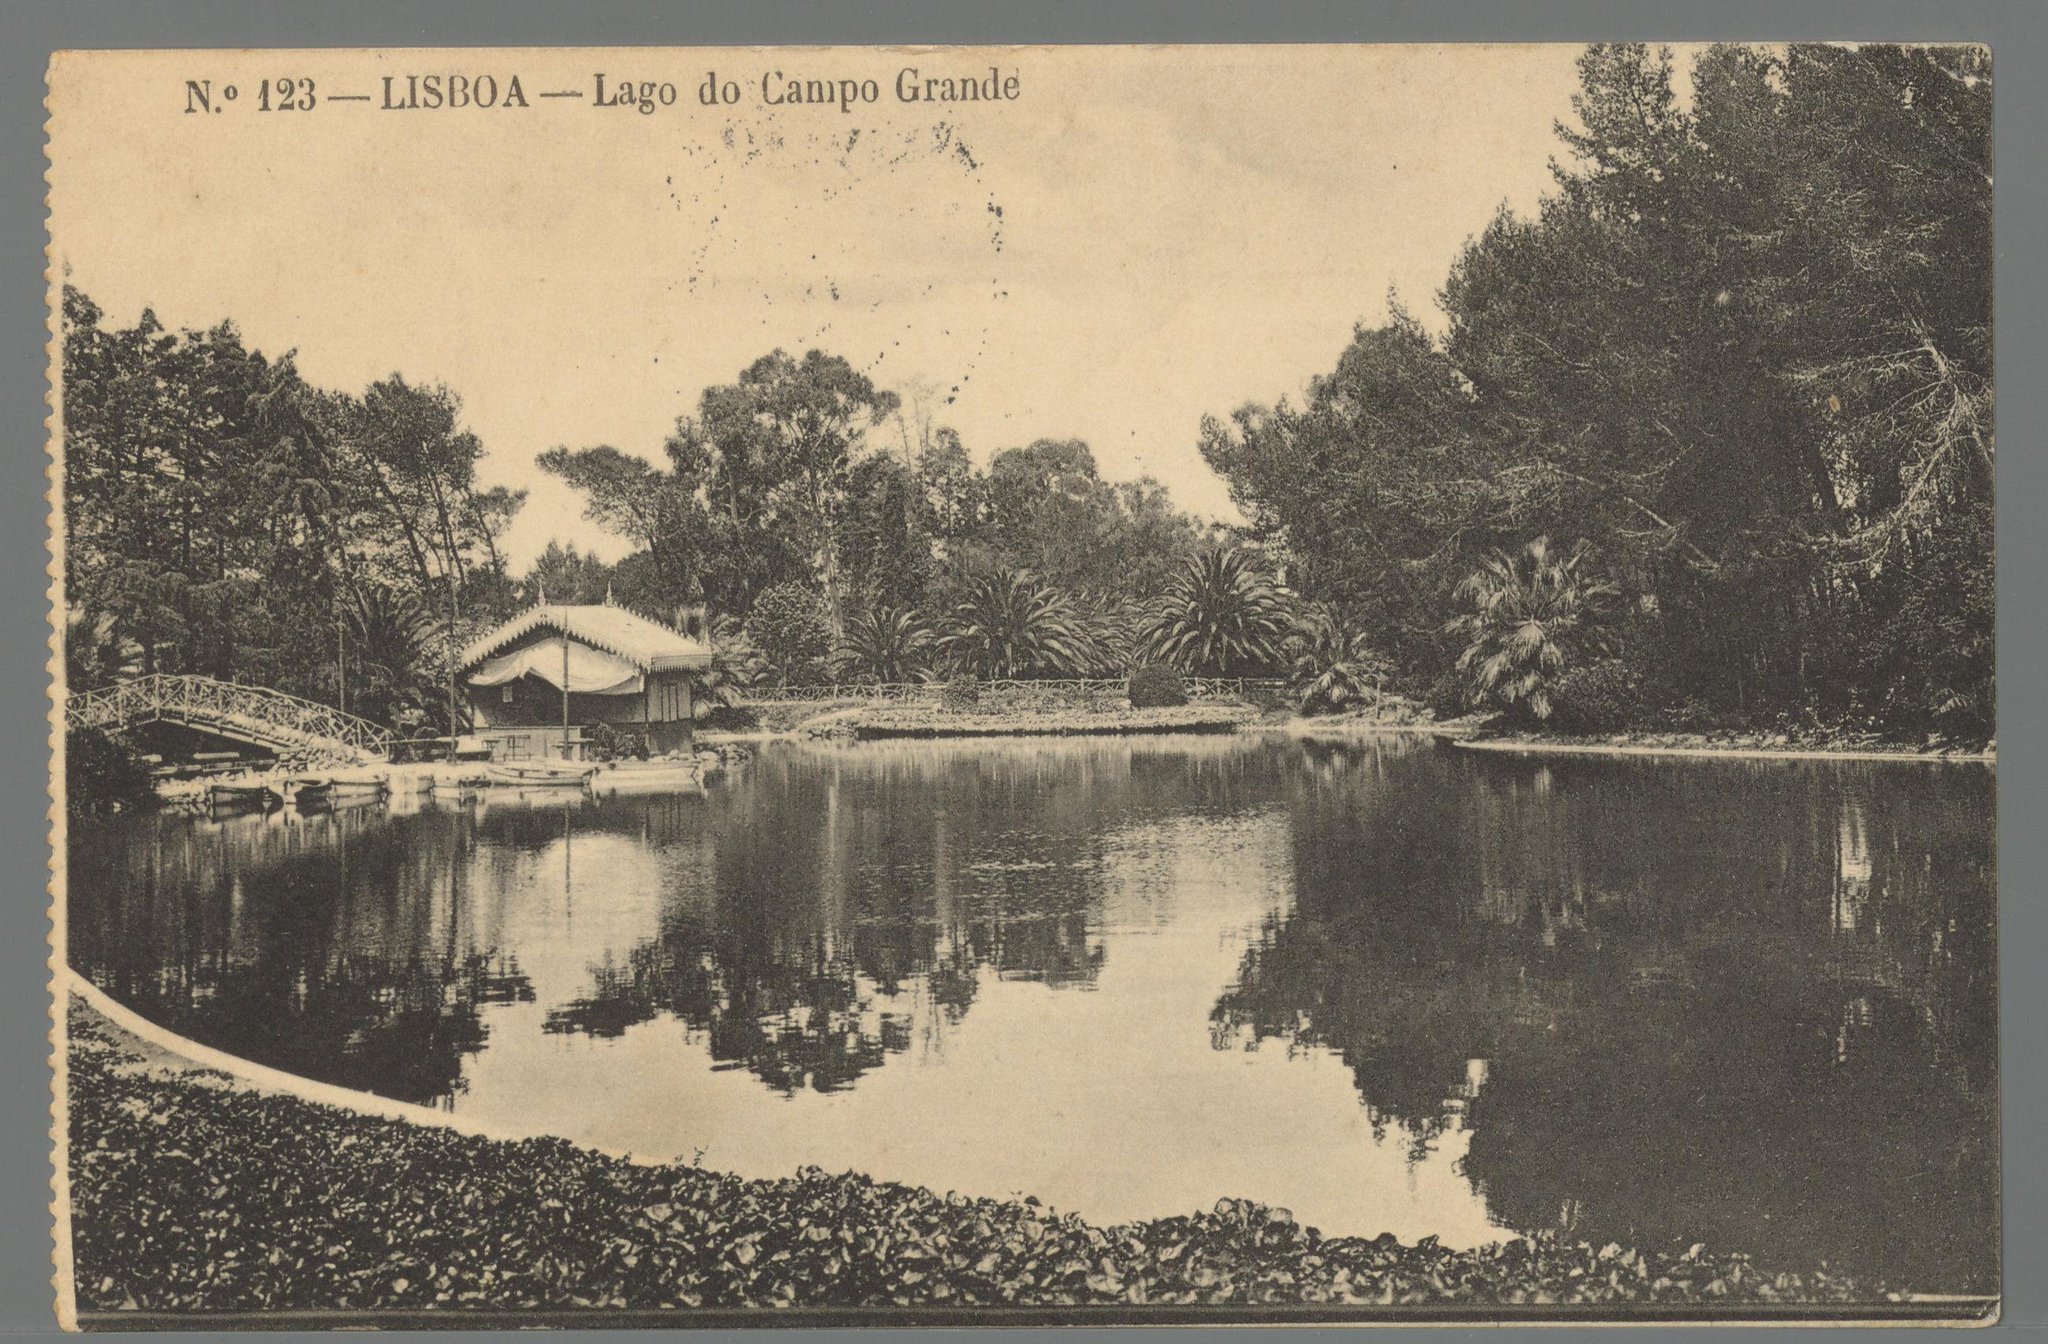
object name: ansichtkaart, prentbriefkaart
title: Lisboa - Lago do Campo Grande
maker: Anonymous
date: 1906-1912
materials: cardboard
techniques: photograph, writing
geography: lisbon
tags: lake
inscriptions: postage stamp